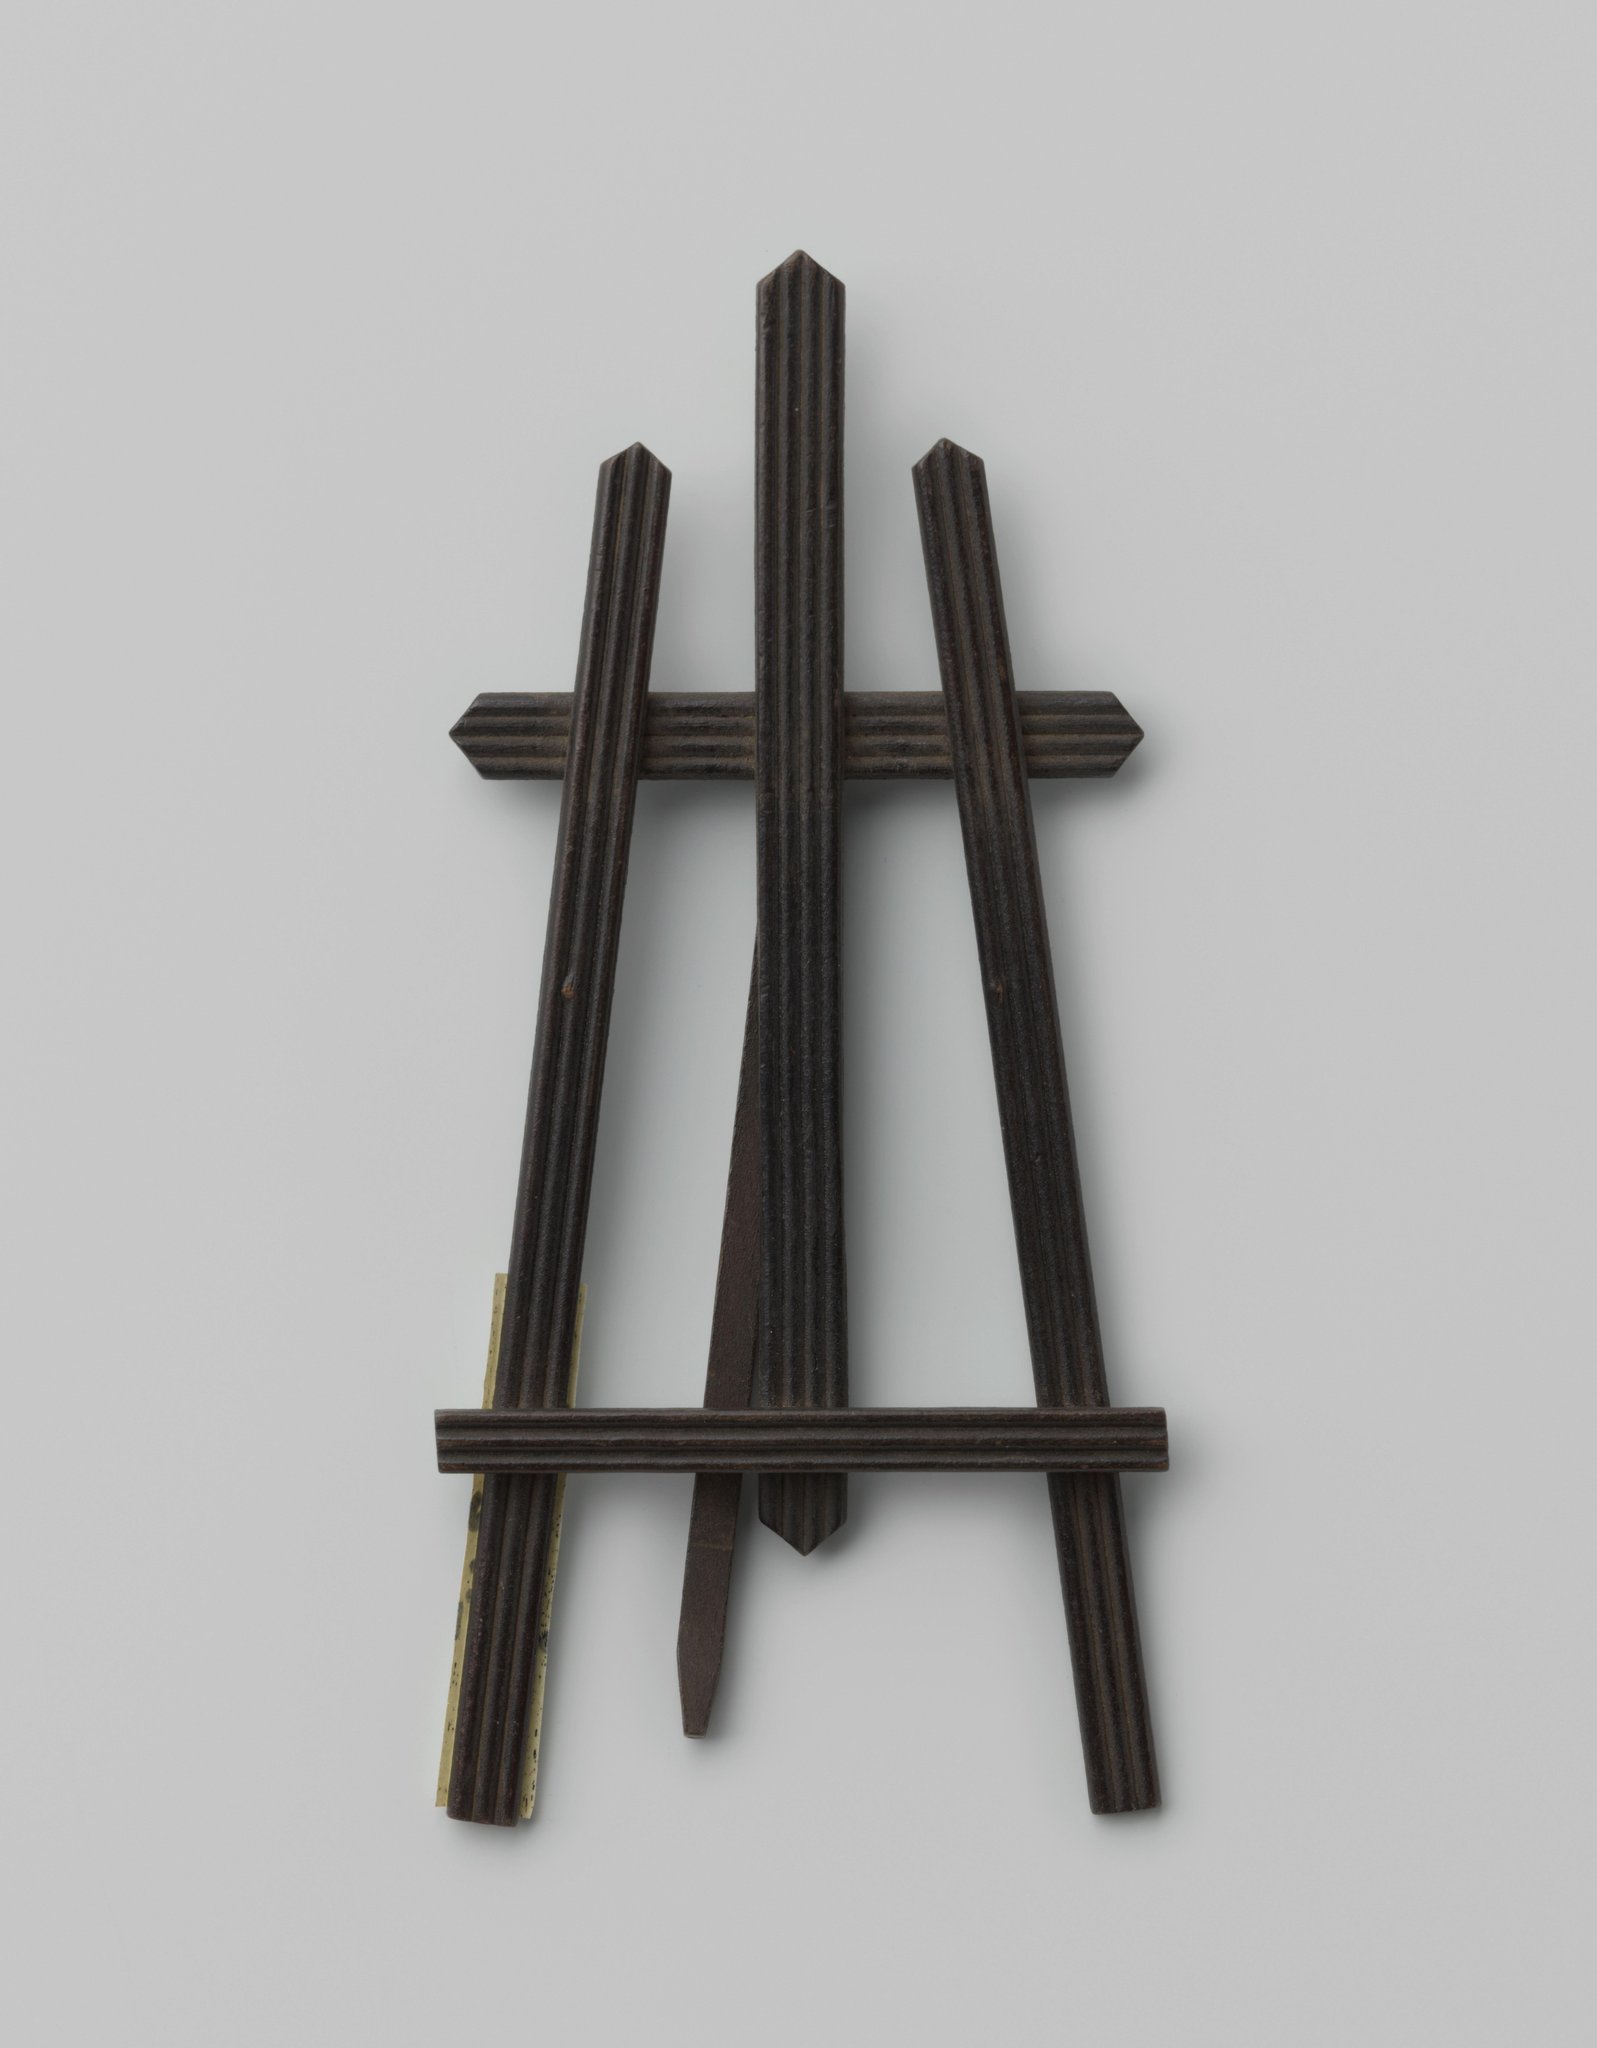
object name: standaard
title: Fotostandaard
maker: Anonymous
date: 1880-1900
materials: metal, wood